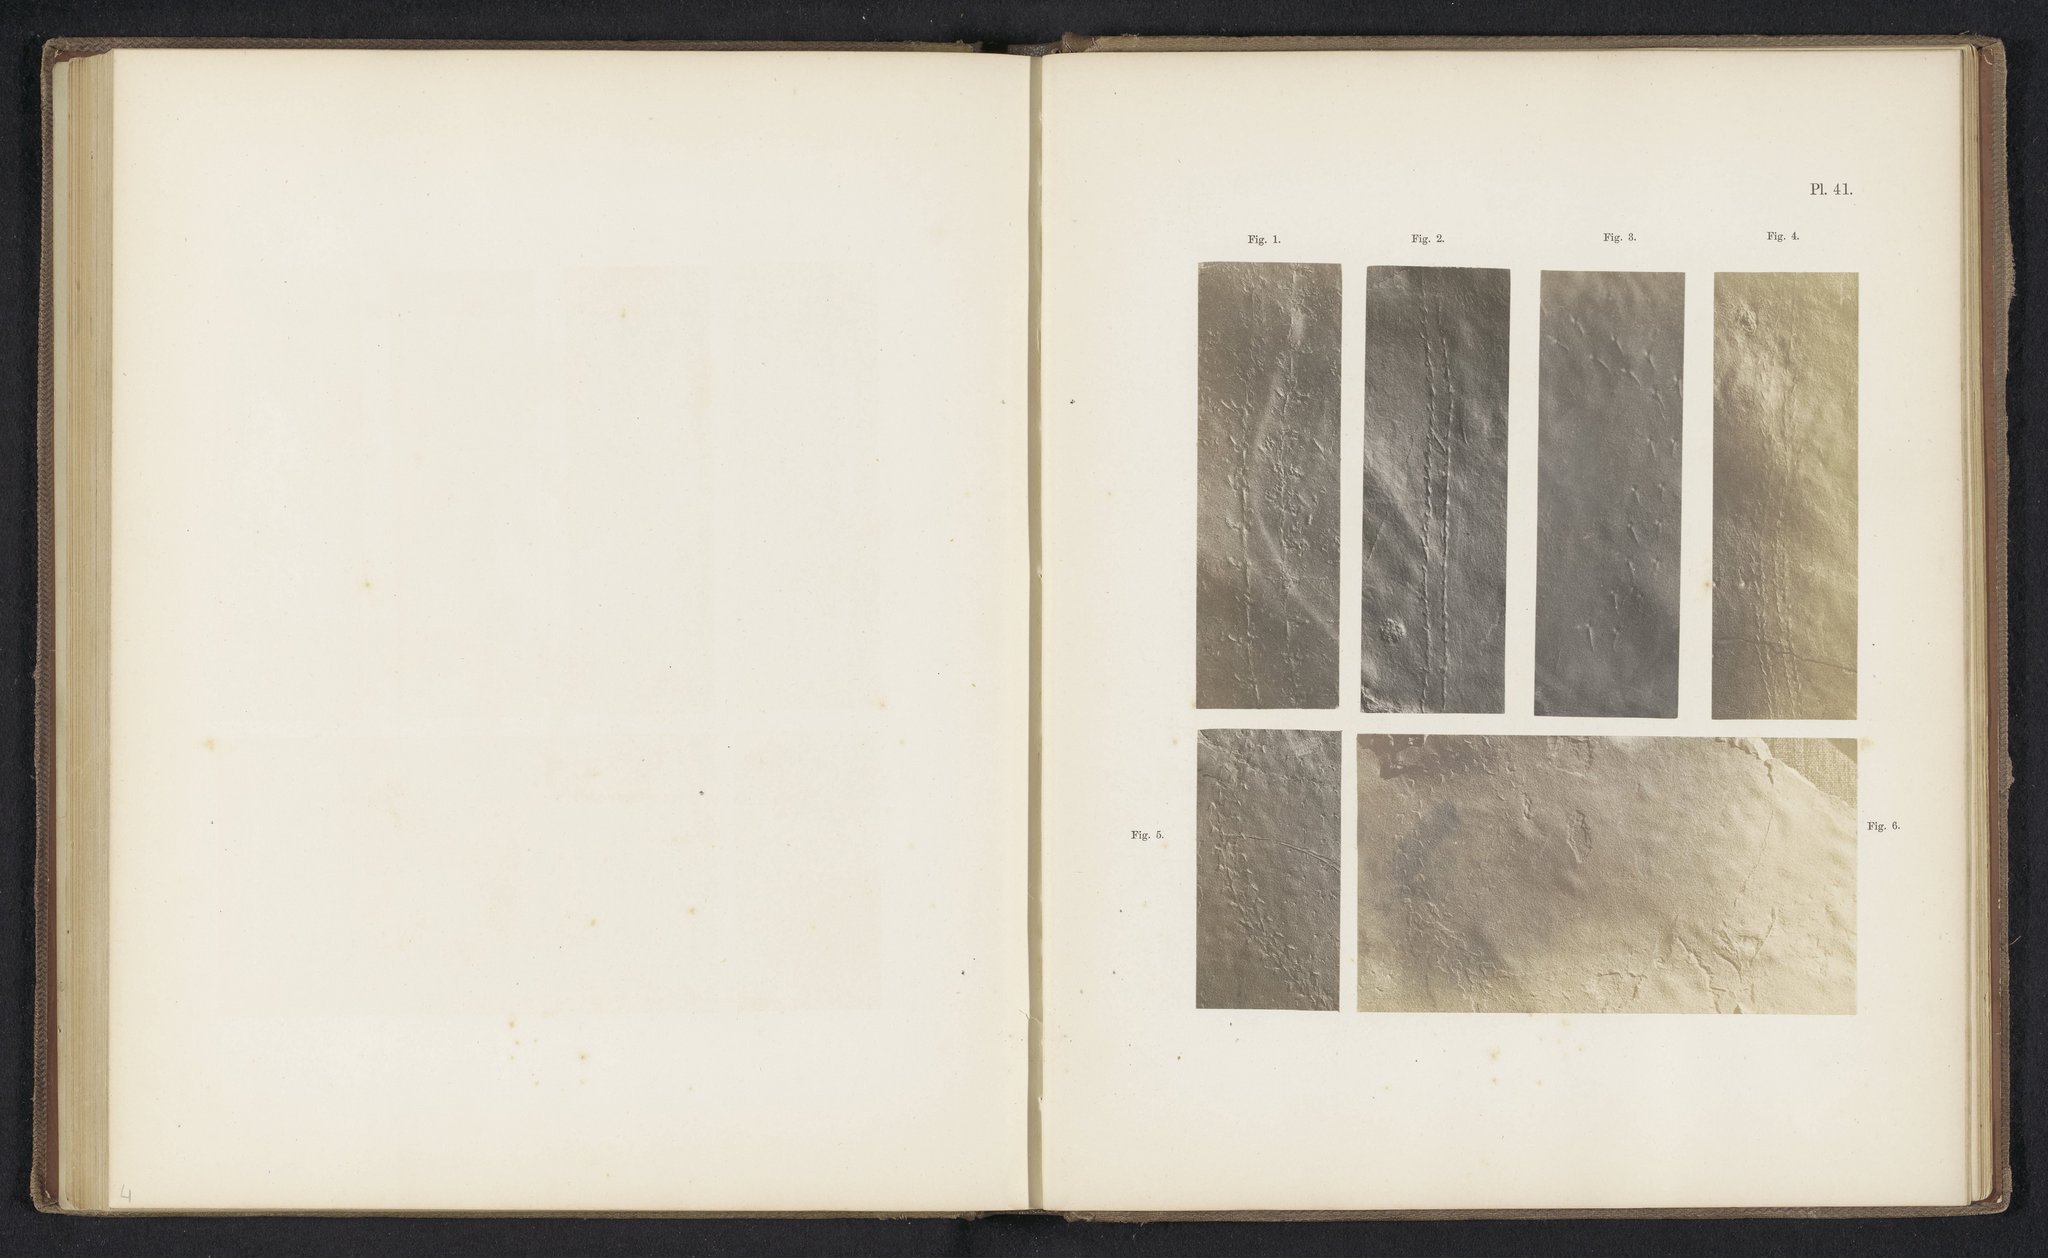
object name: page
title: Voetsporen van zes insecten of schaaldieren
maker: Anonymous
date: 1850-1861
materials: paper, photographic support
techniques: salted paper print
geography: united states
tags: foot-print, track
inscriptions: number: ‘Pl. 41.’, number: ‘Fig. 1. (...) Fig. 6.’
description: Fig. 1. een spoor van een Lithographus hieroglyphicus, Fig. 2. een spoor van een Bifurculapes tuberculatus, Fig. 3. een spoor van een Conopsoides larvalis, Fig. 4. een spoor van een Bifurculapes, Fig. 5. en Fig. 6. een spoor van een Bifurculapes laquaetus.